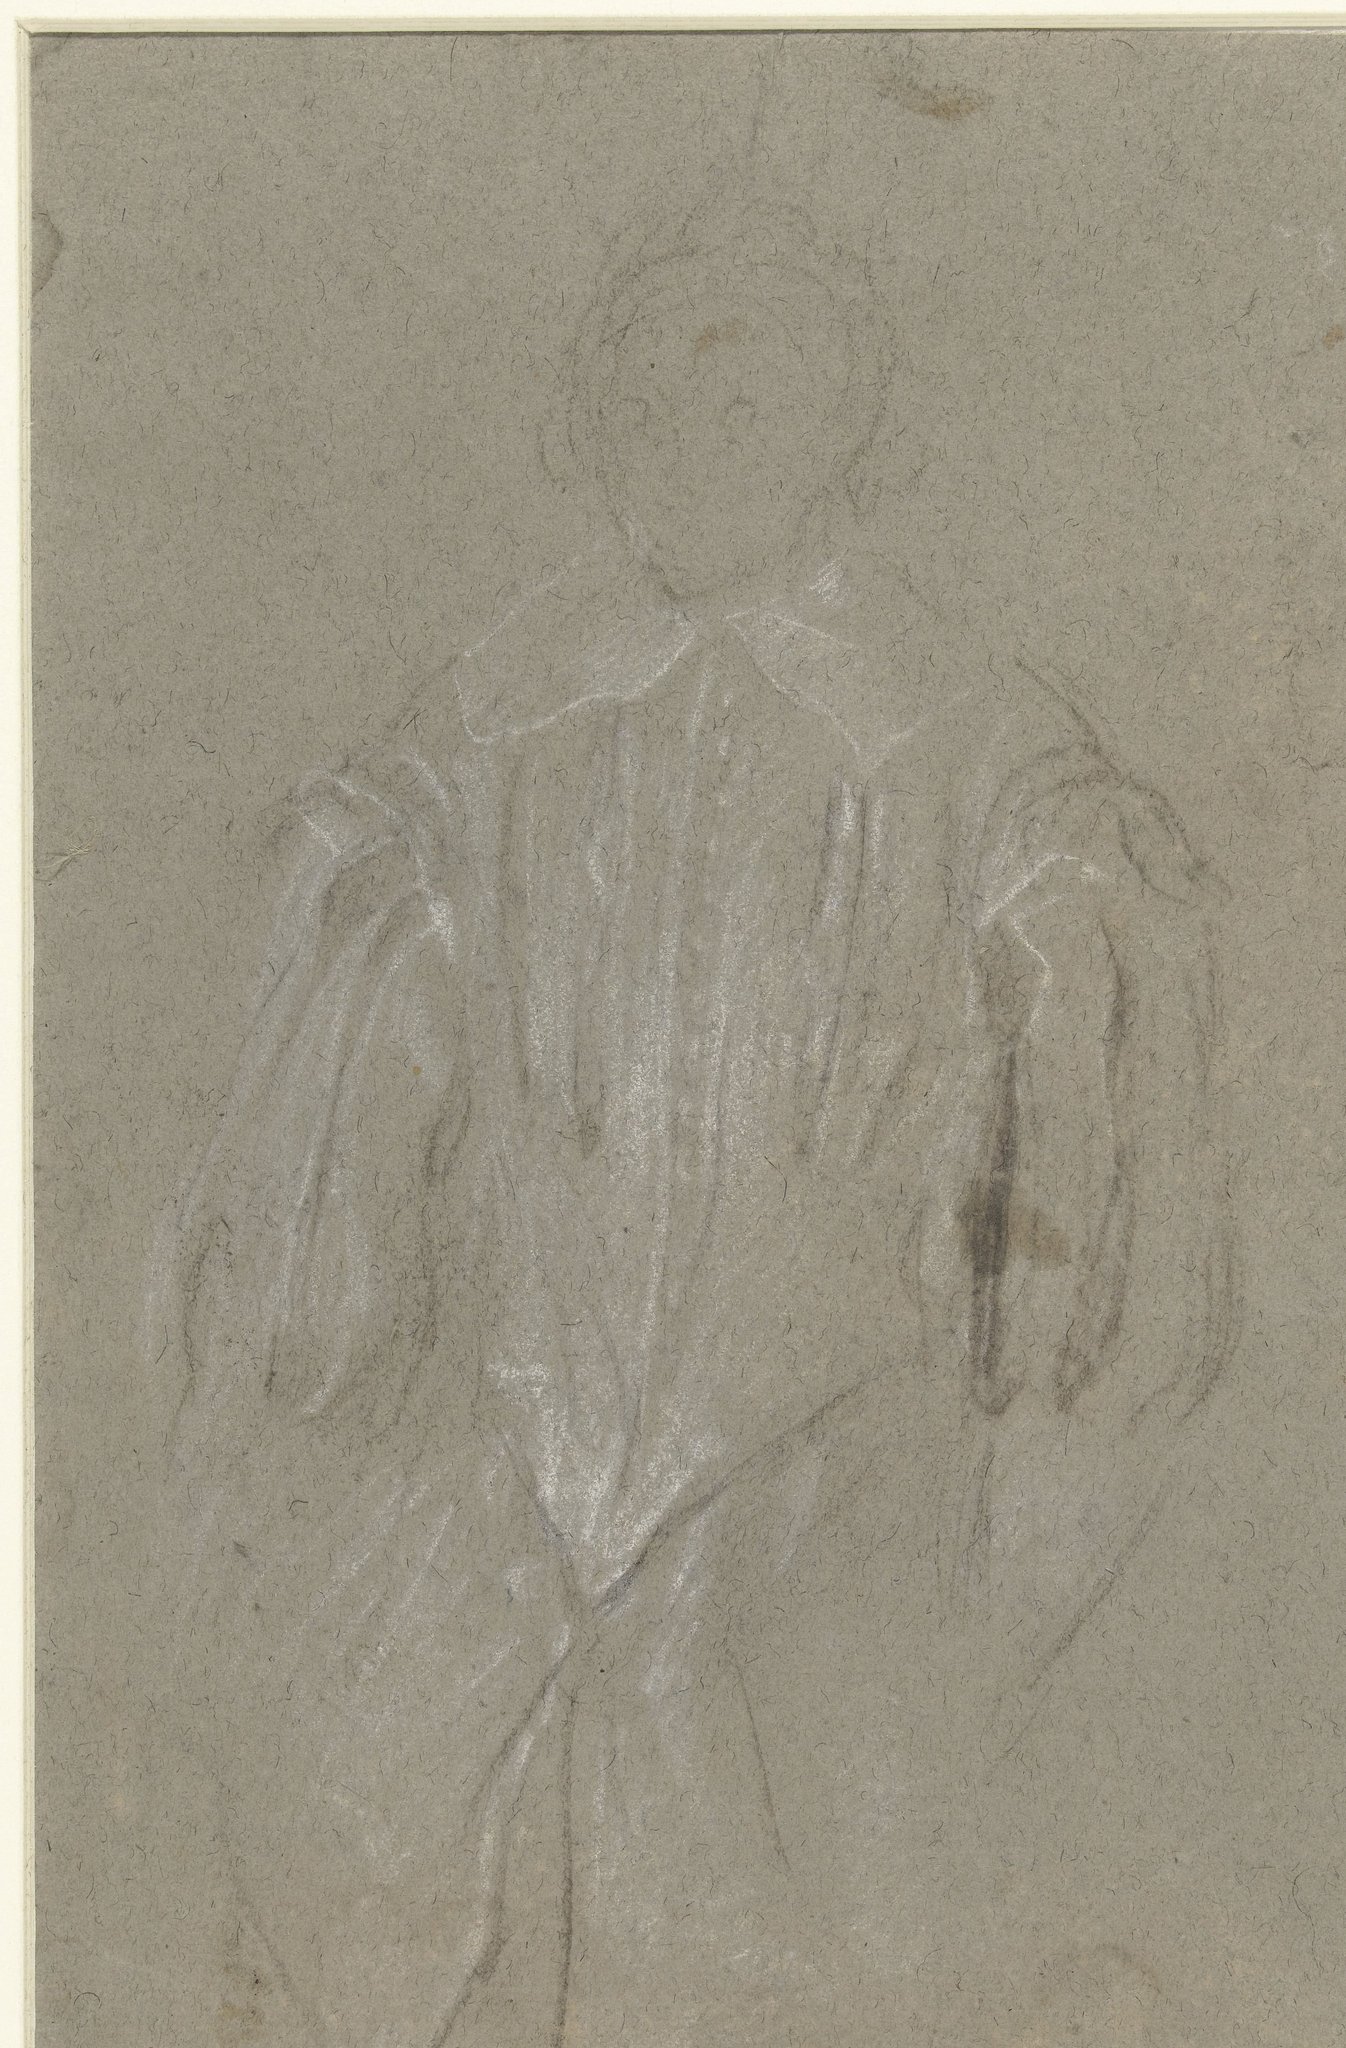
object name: drawing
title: Schetsbladen met figuurstudies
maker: Anonymous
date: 1610-1630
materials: chalk, paper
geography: verona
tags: standing figure